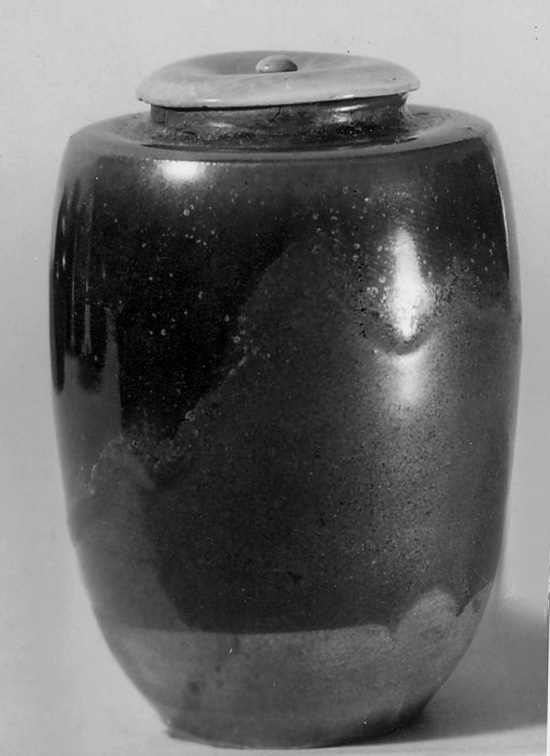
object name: tea jar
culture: japanese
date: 1701-1800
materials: clay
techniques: overglaze, underglaze